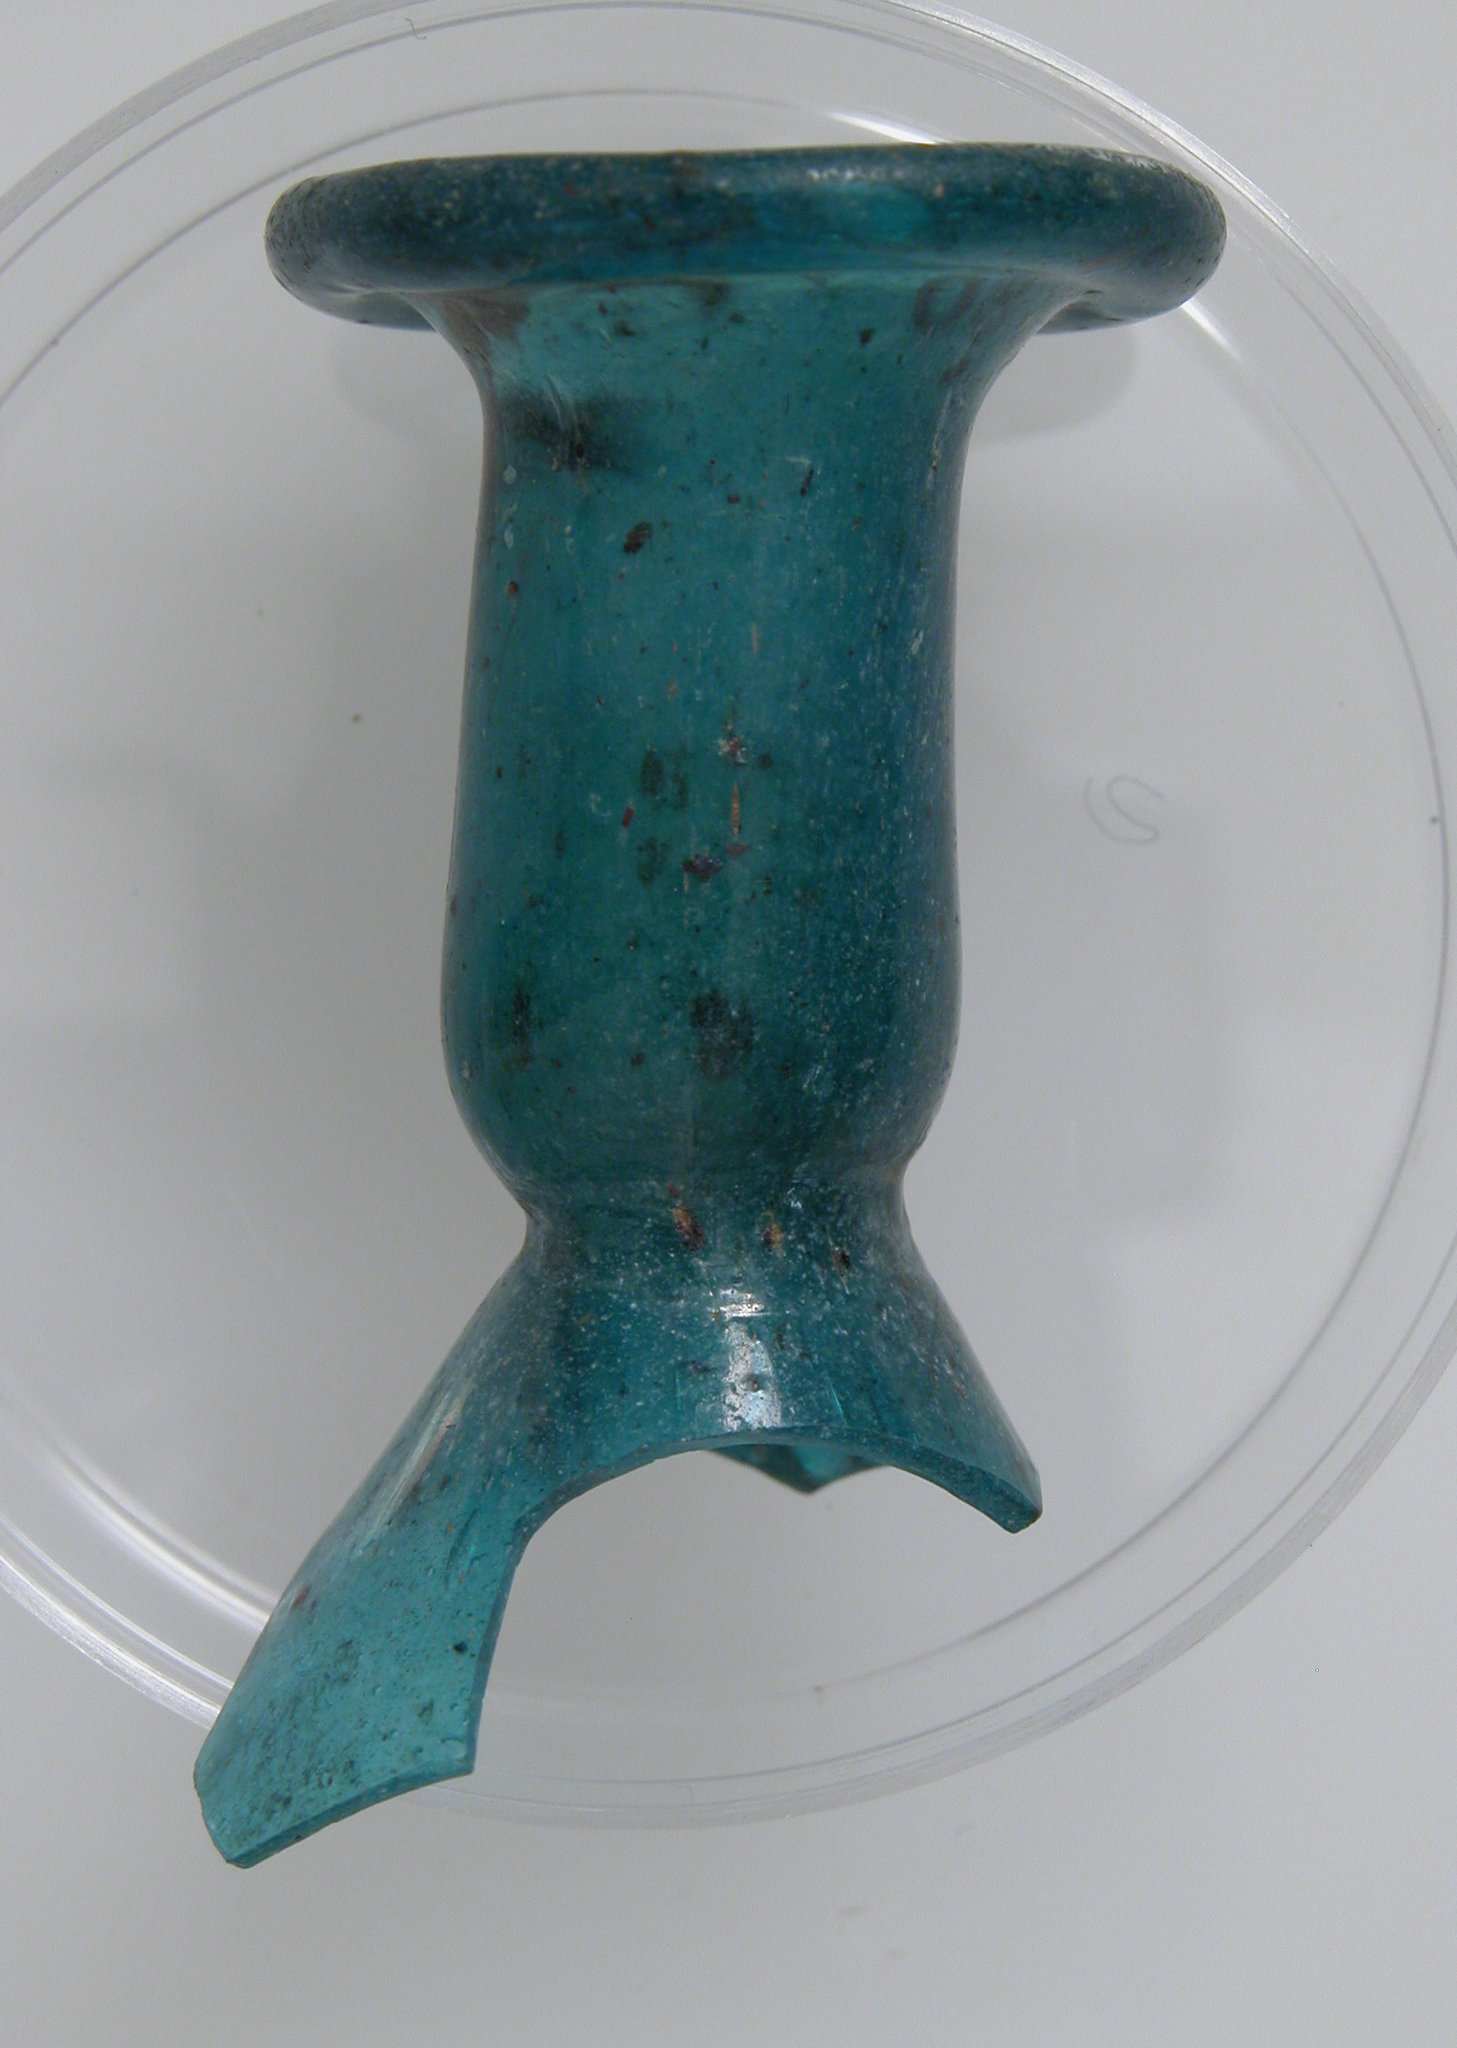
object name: fragment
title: Neck of a Bottle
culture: coptic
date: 301-433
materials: glass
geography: egypt